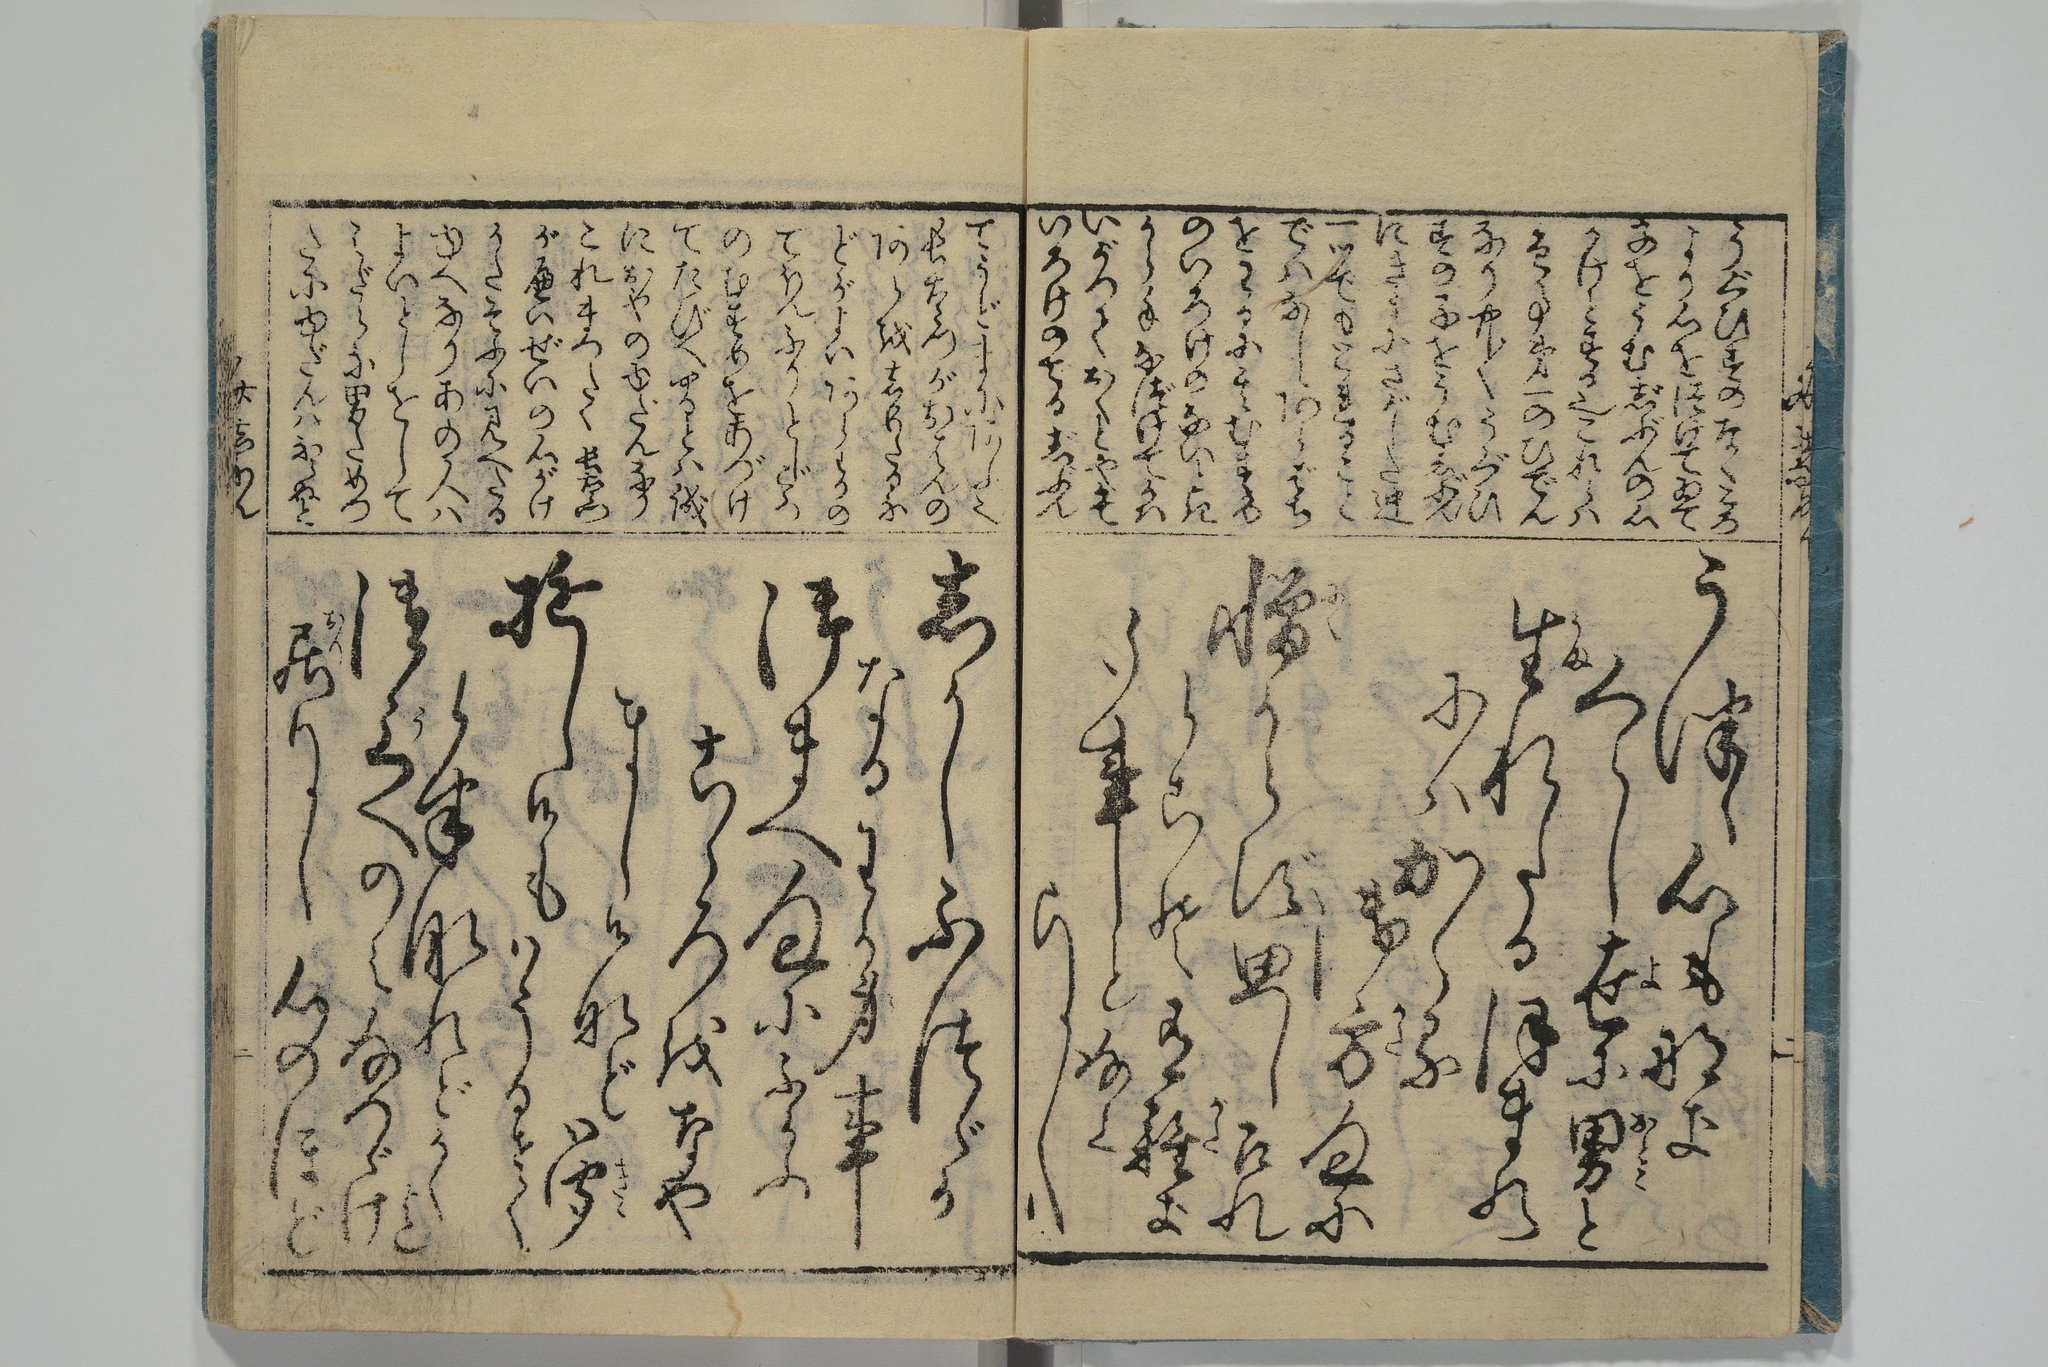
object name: illustrated book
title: Teaching Calligraphy (Fumi no hayashi) ふみ(文)のはやし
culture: japanese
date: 1701-1800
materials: ink, paper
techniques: woodblock print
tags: calligraphy